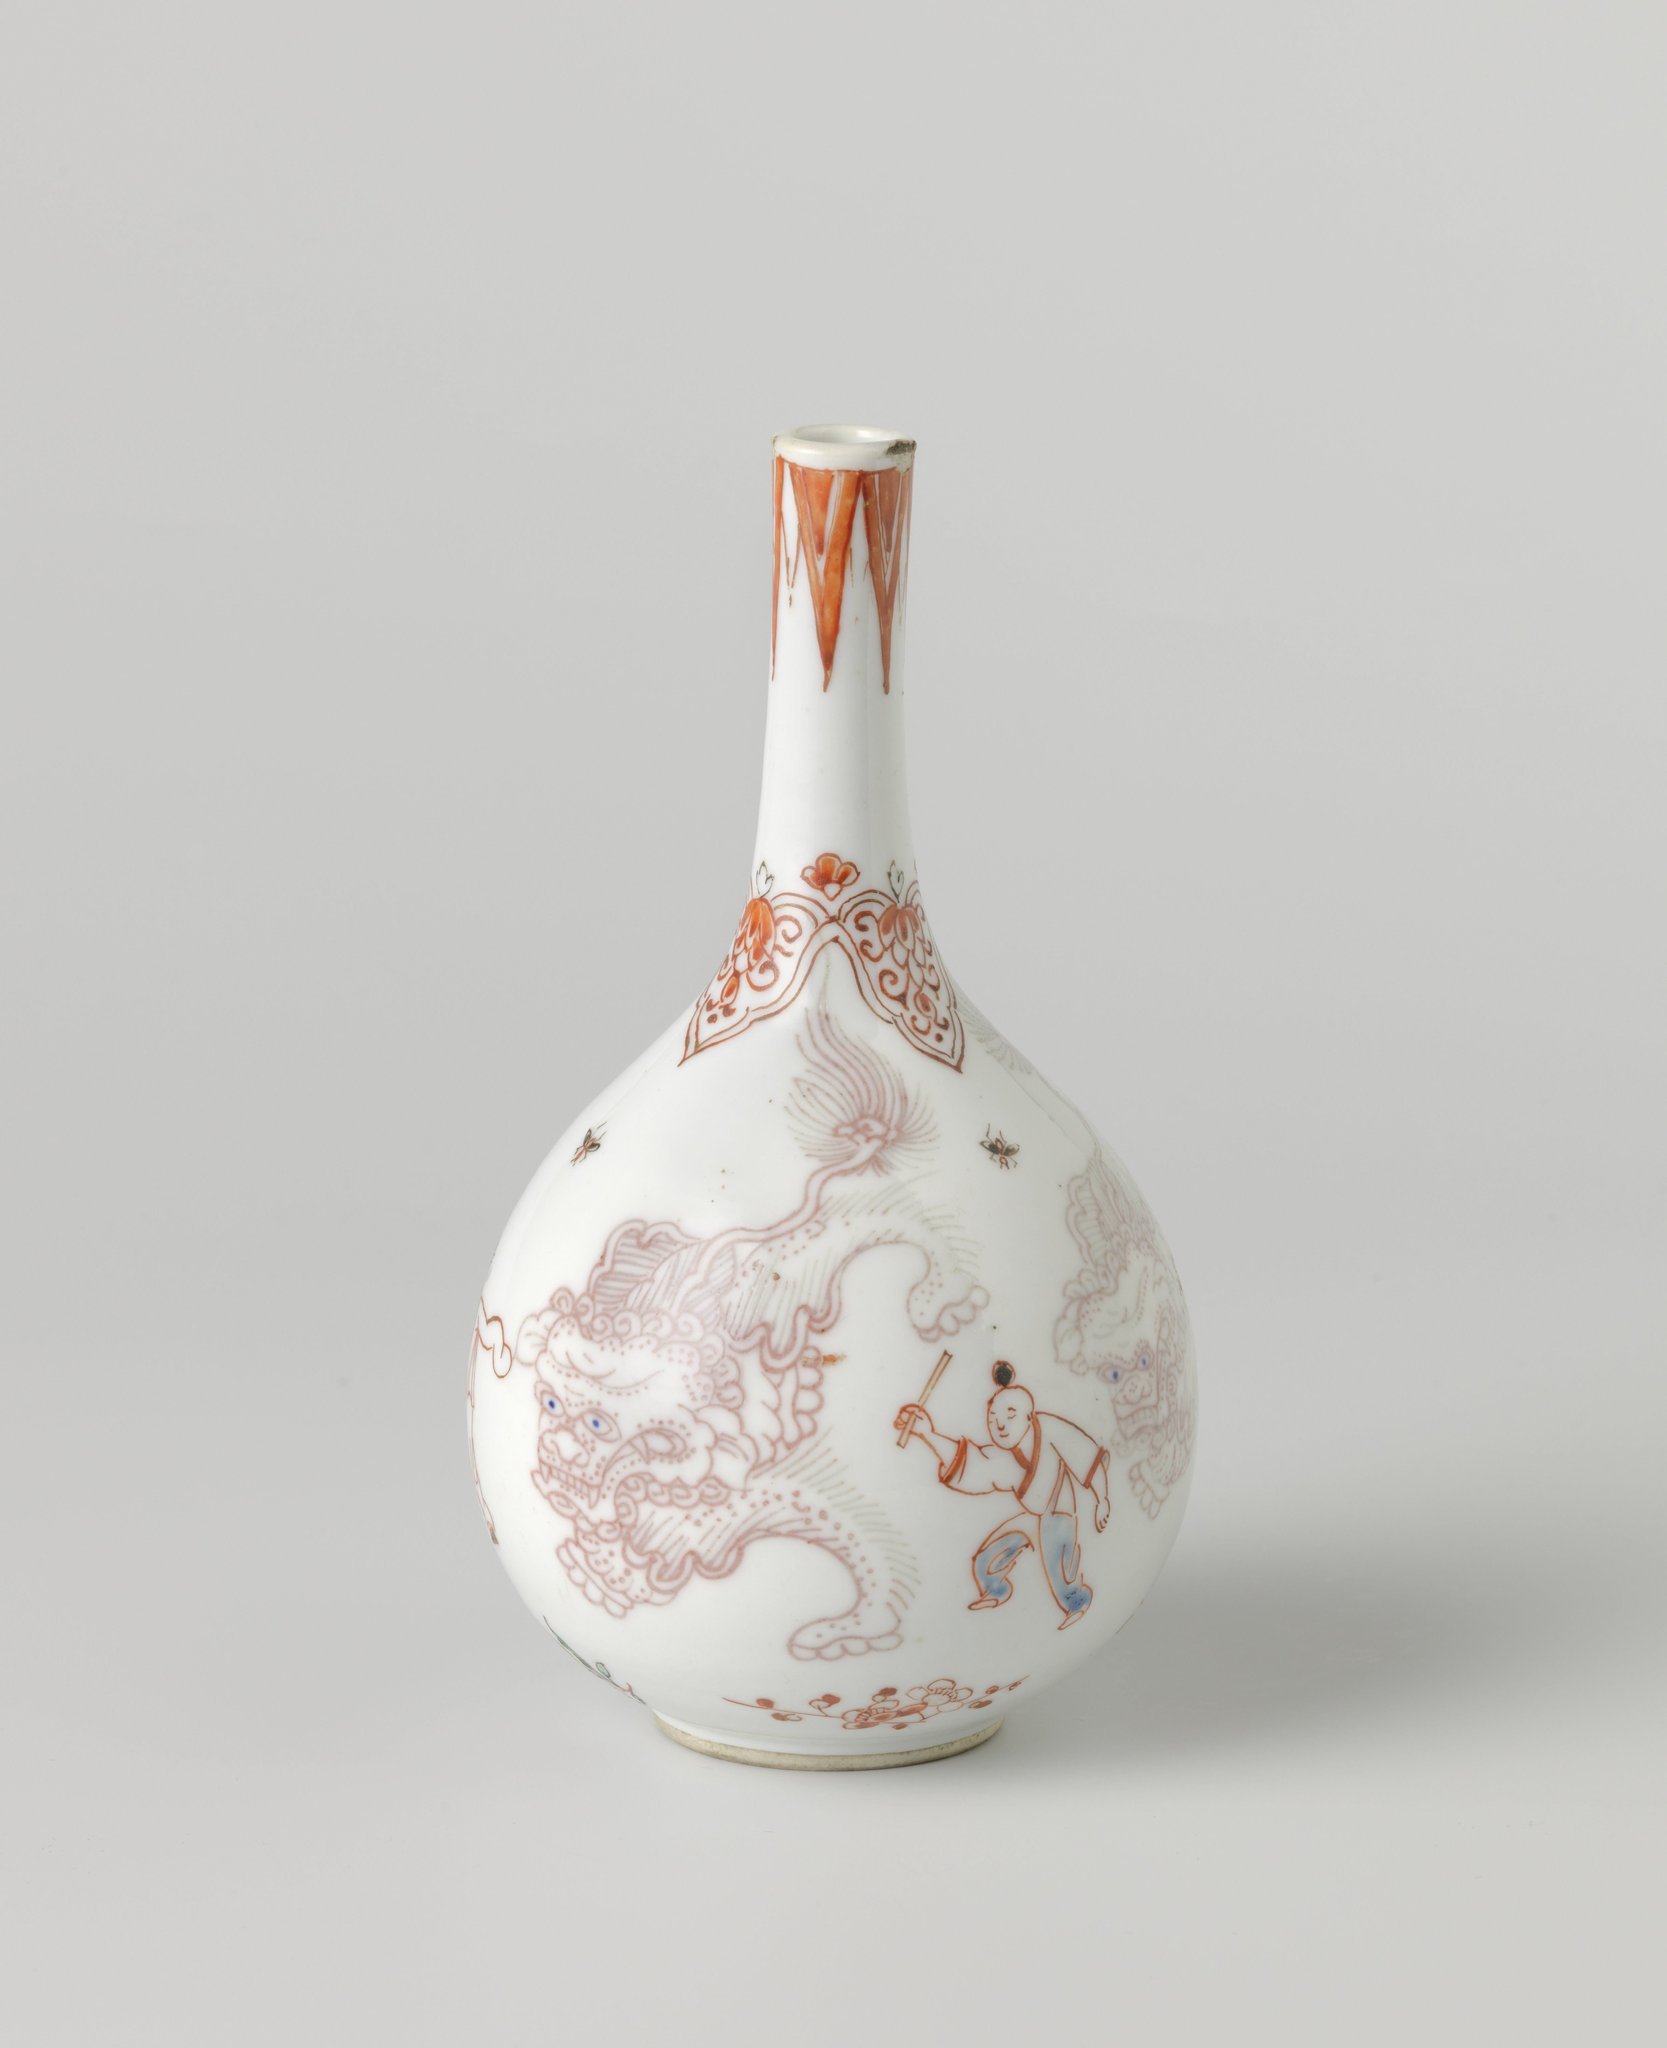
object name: vase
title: Bottle vase with three shishi and playing boys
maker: Anonymous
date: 1700-1724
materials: cobalt, glaze, paint, porcelain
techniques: firing, turning, vitrification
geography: china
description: Flesvormige vaas van porselein, beschilderd in onderglazuur blauw en rood en op het glazuur blauw, rood, groen, geel en zwart. Origineel alleen versierd met de drie shishi (leeuwhond), in Europa zijn op het lichaam drie spelende jongens en bloemtakken, op de schouder afhangende cartouches gevuld met lotusranken en op de rand afhangende puntige bladmotieven toegevoegd. Twee chips in de rand. Onderglazuur blauw met koperrood. Overgedecoreerd (Amsterdams bont).